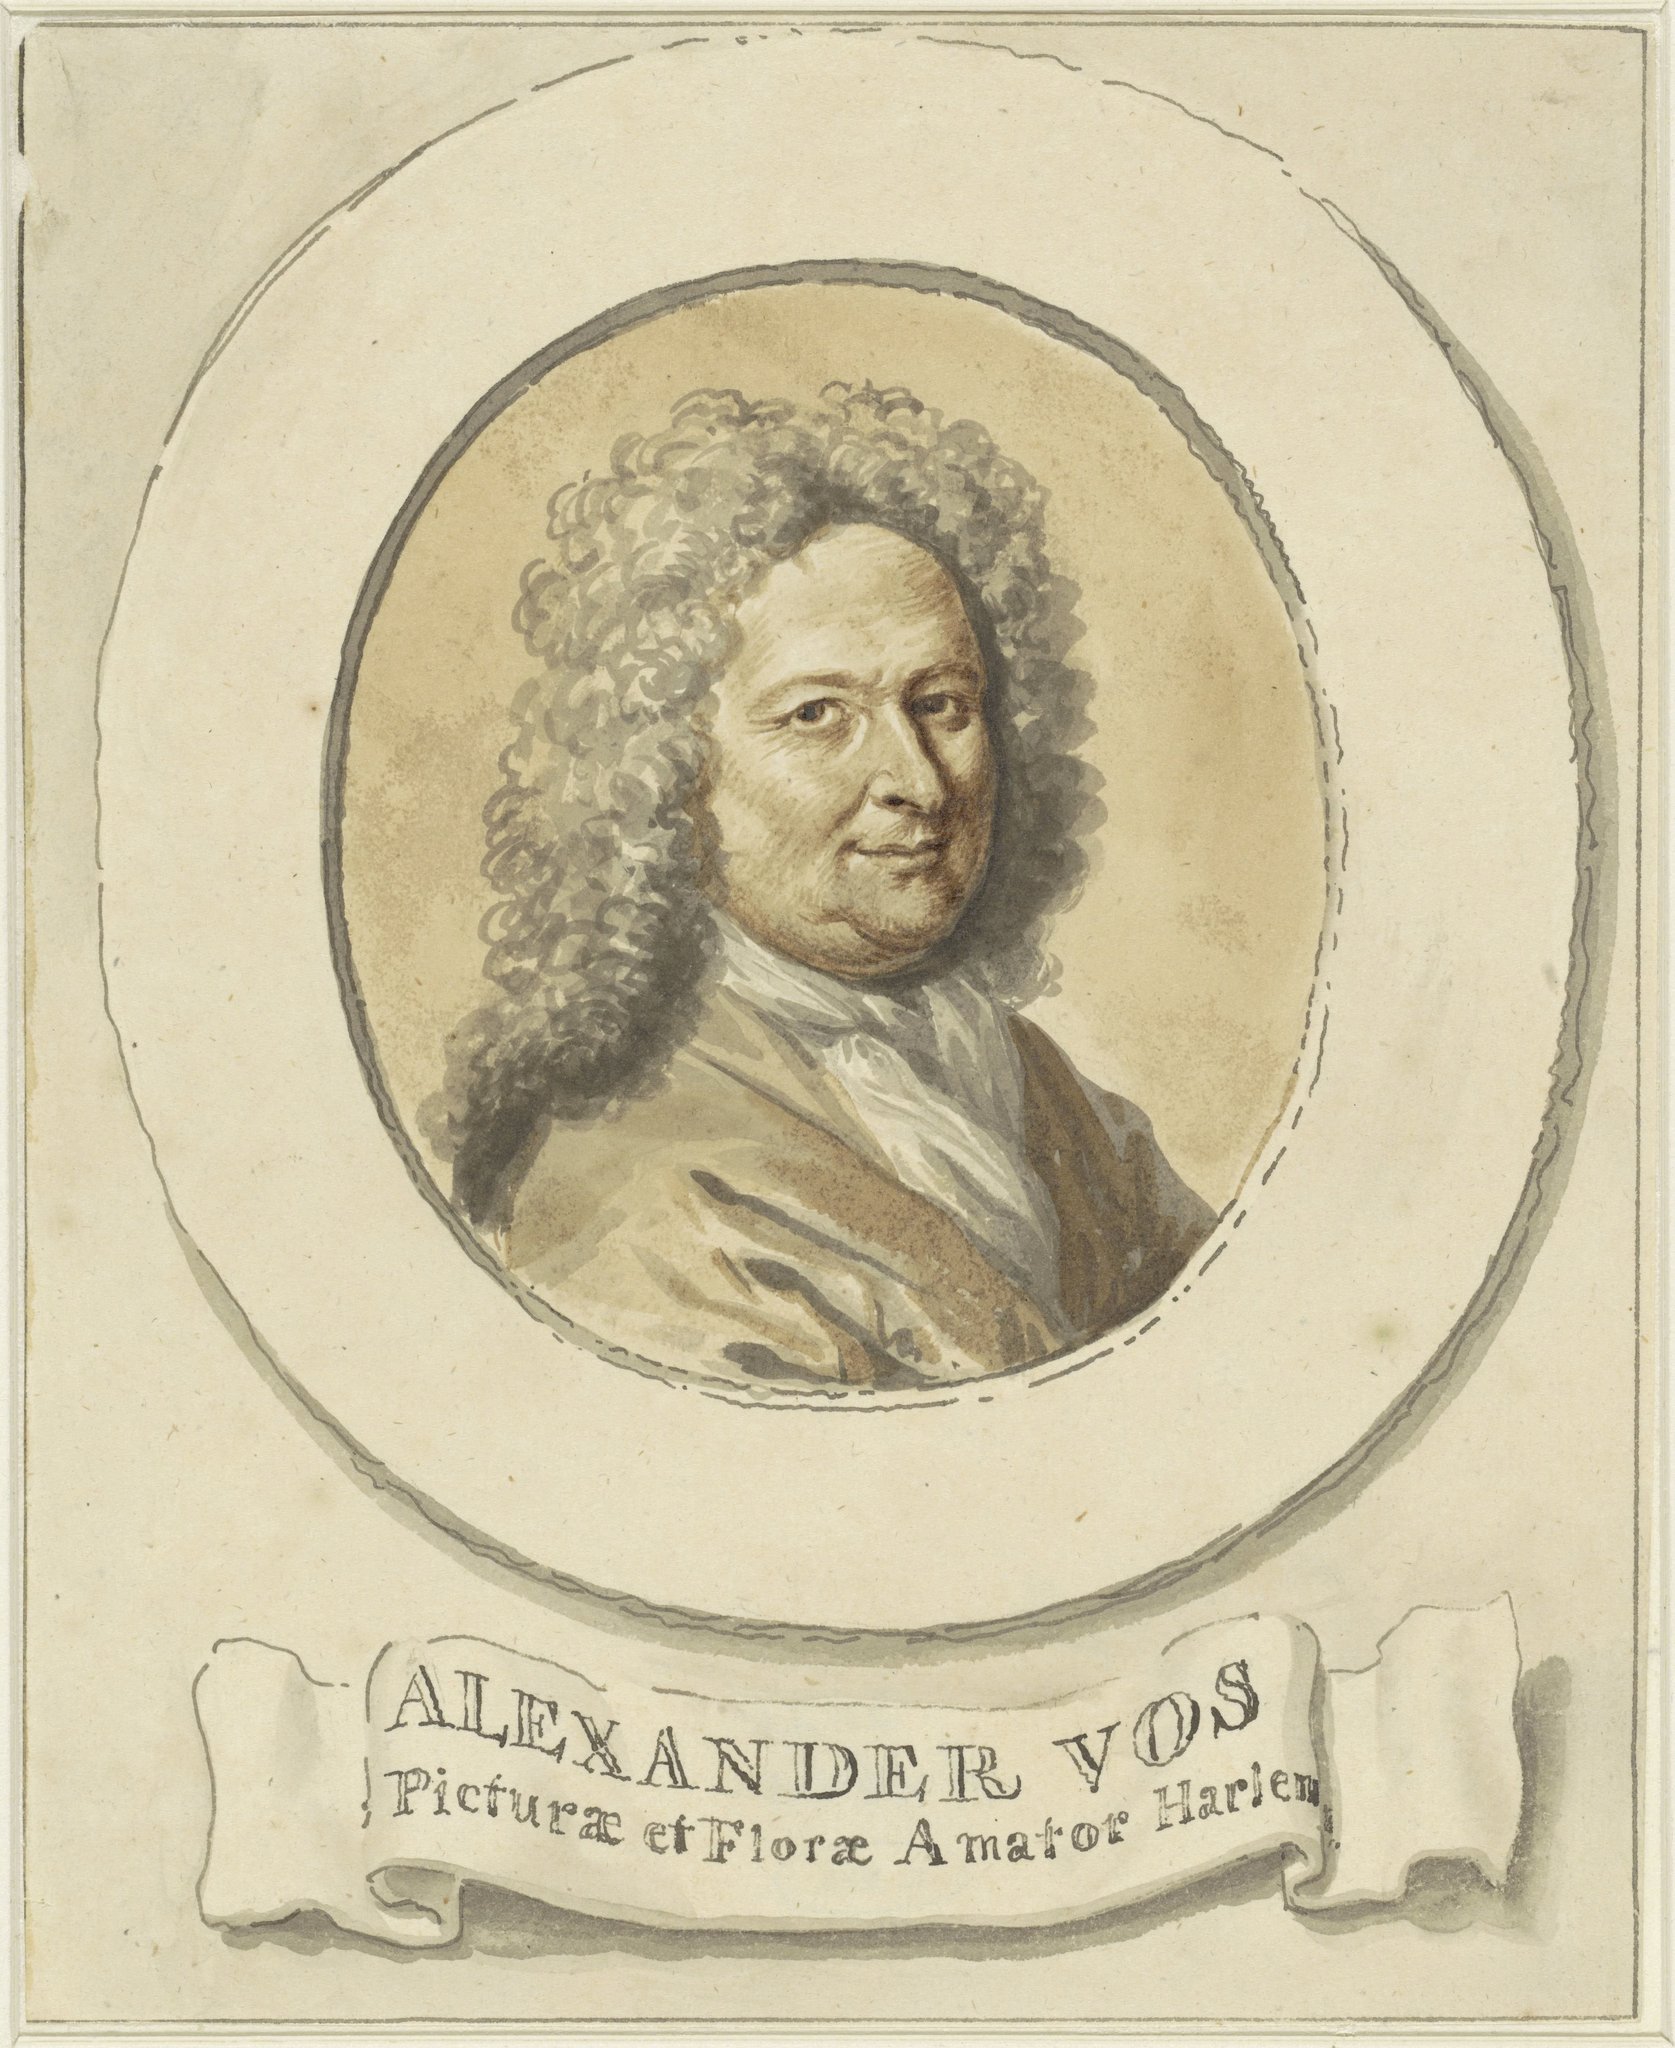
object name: drawing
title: Portret van Alexander Vos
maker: tako hajo jelgersma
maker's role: draughtsman, painter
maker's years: 1702-1795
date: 1712-1795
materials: paper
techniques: brush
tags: historical persons, portrait, self-portrait of painter, portrait, self-portrait of artist